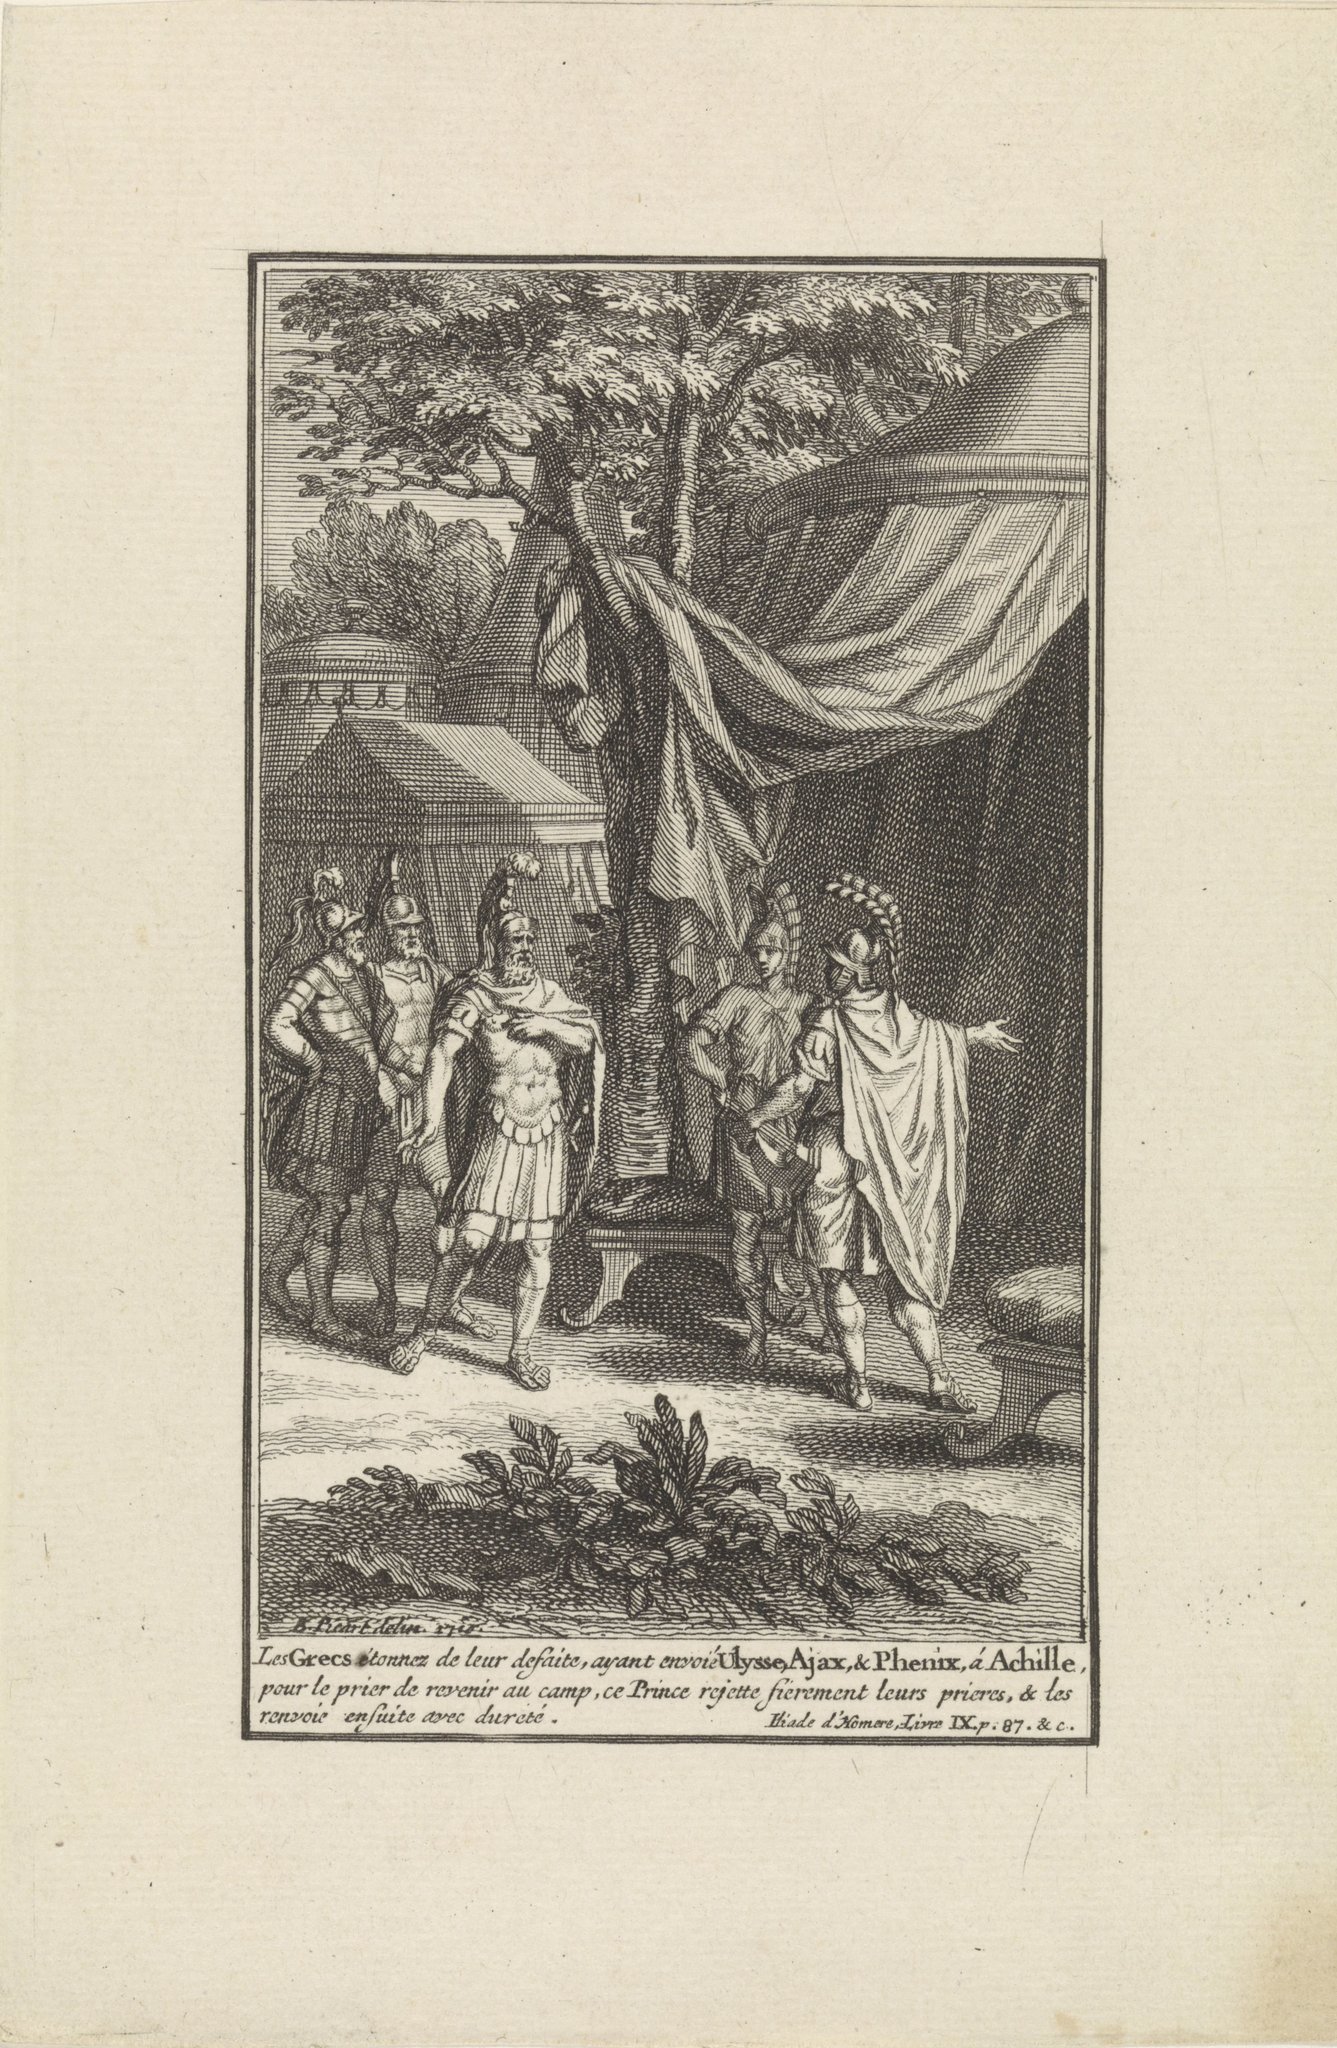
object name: book illustration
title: Achilles weigert de geschenken van Agamemnon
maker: bernard picart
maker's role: draughtsman, print maker, publisher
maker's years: 1673-1733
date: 1710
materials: paper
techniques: engraving, etching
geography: amsterdam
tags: agamemnon repents and sends envoys with gifts to achilles, who refuses them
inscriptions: collector's mark: Lugt 2228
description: Phoenix, Ajax en Odysseus bezoeken Achilles en bieden hem namens koning Agamemnon geschenken aan, om hem terug te winnen. Hij weigert ze. In de marge een onderschrift in het Frans.